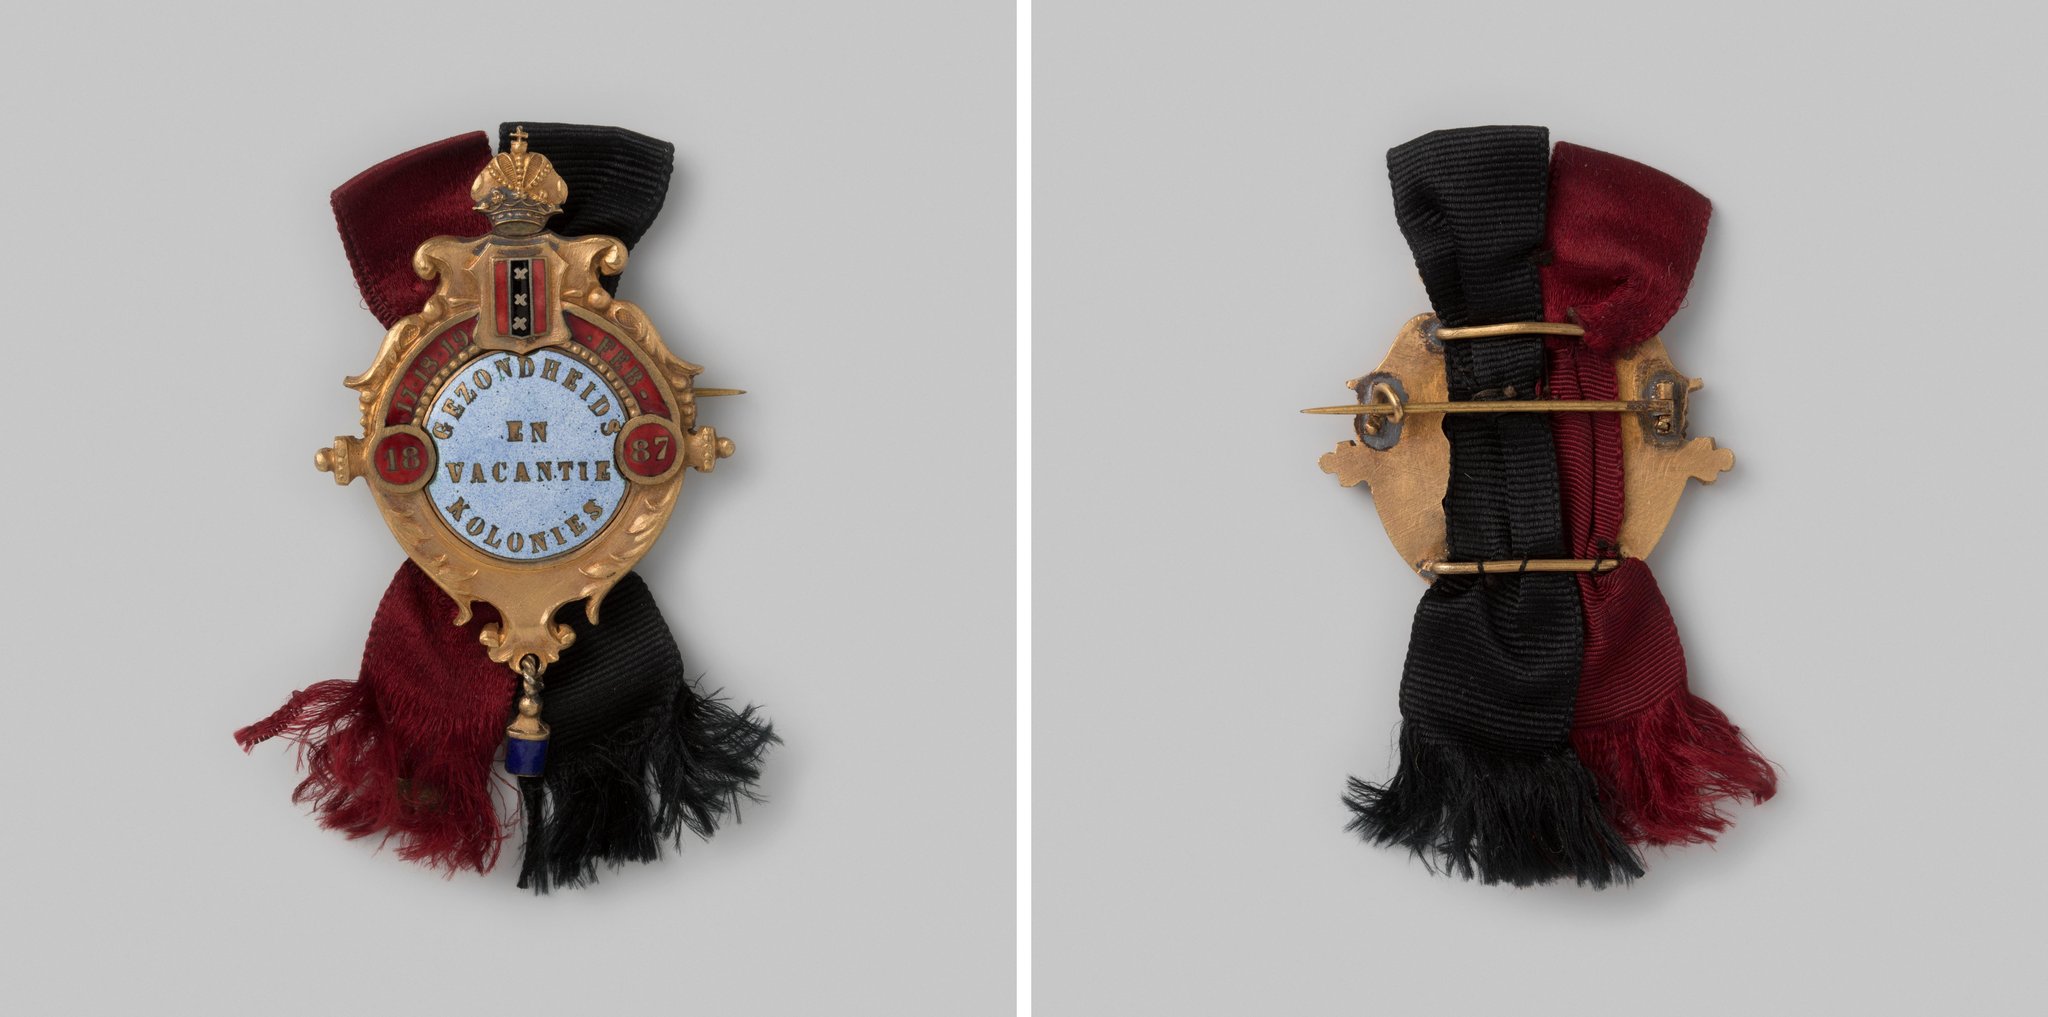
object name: history medal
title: Insigne van de Vereeniging Gezondheids- en Vacantiekolonies te Amsterdam 1887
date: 1887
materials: brass, textile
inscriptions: inscription: ‘17-18-19 - FEB / 18 - 87 / GEZONDHEIDS / EN / VAKANTIE / KOLONIES’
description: Messing broche op aangehecht rood-zwart lint, in de vorm van een druppelvormige gekroonde cartouche, waarop blauw en rood geëmailleerde velden met opschriften onder een rood en zwart geëmaileerd Amsterdams wapenschild, met een kleine blauw geëmaillerde flesvormige hanger.